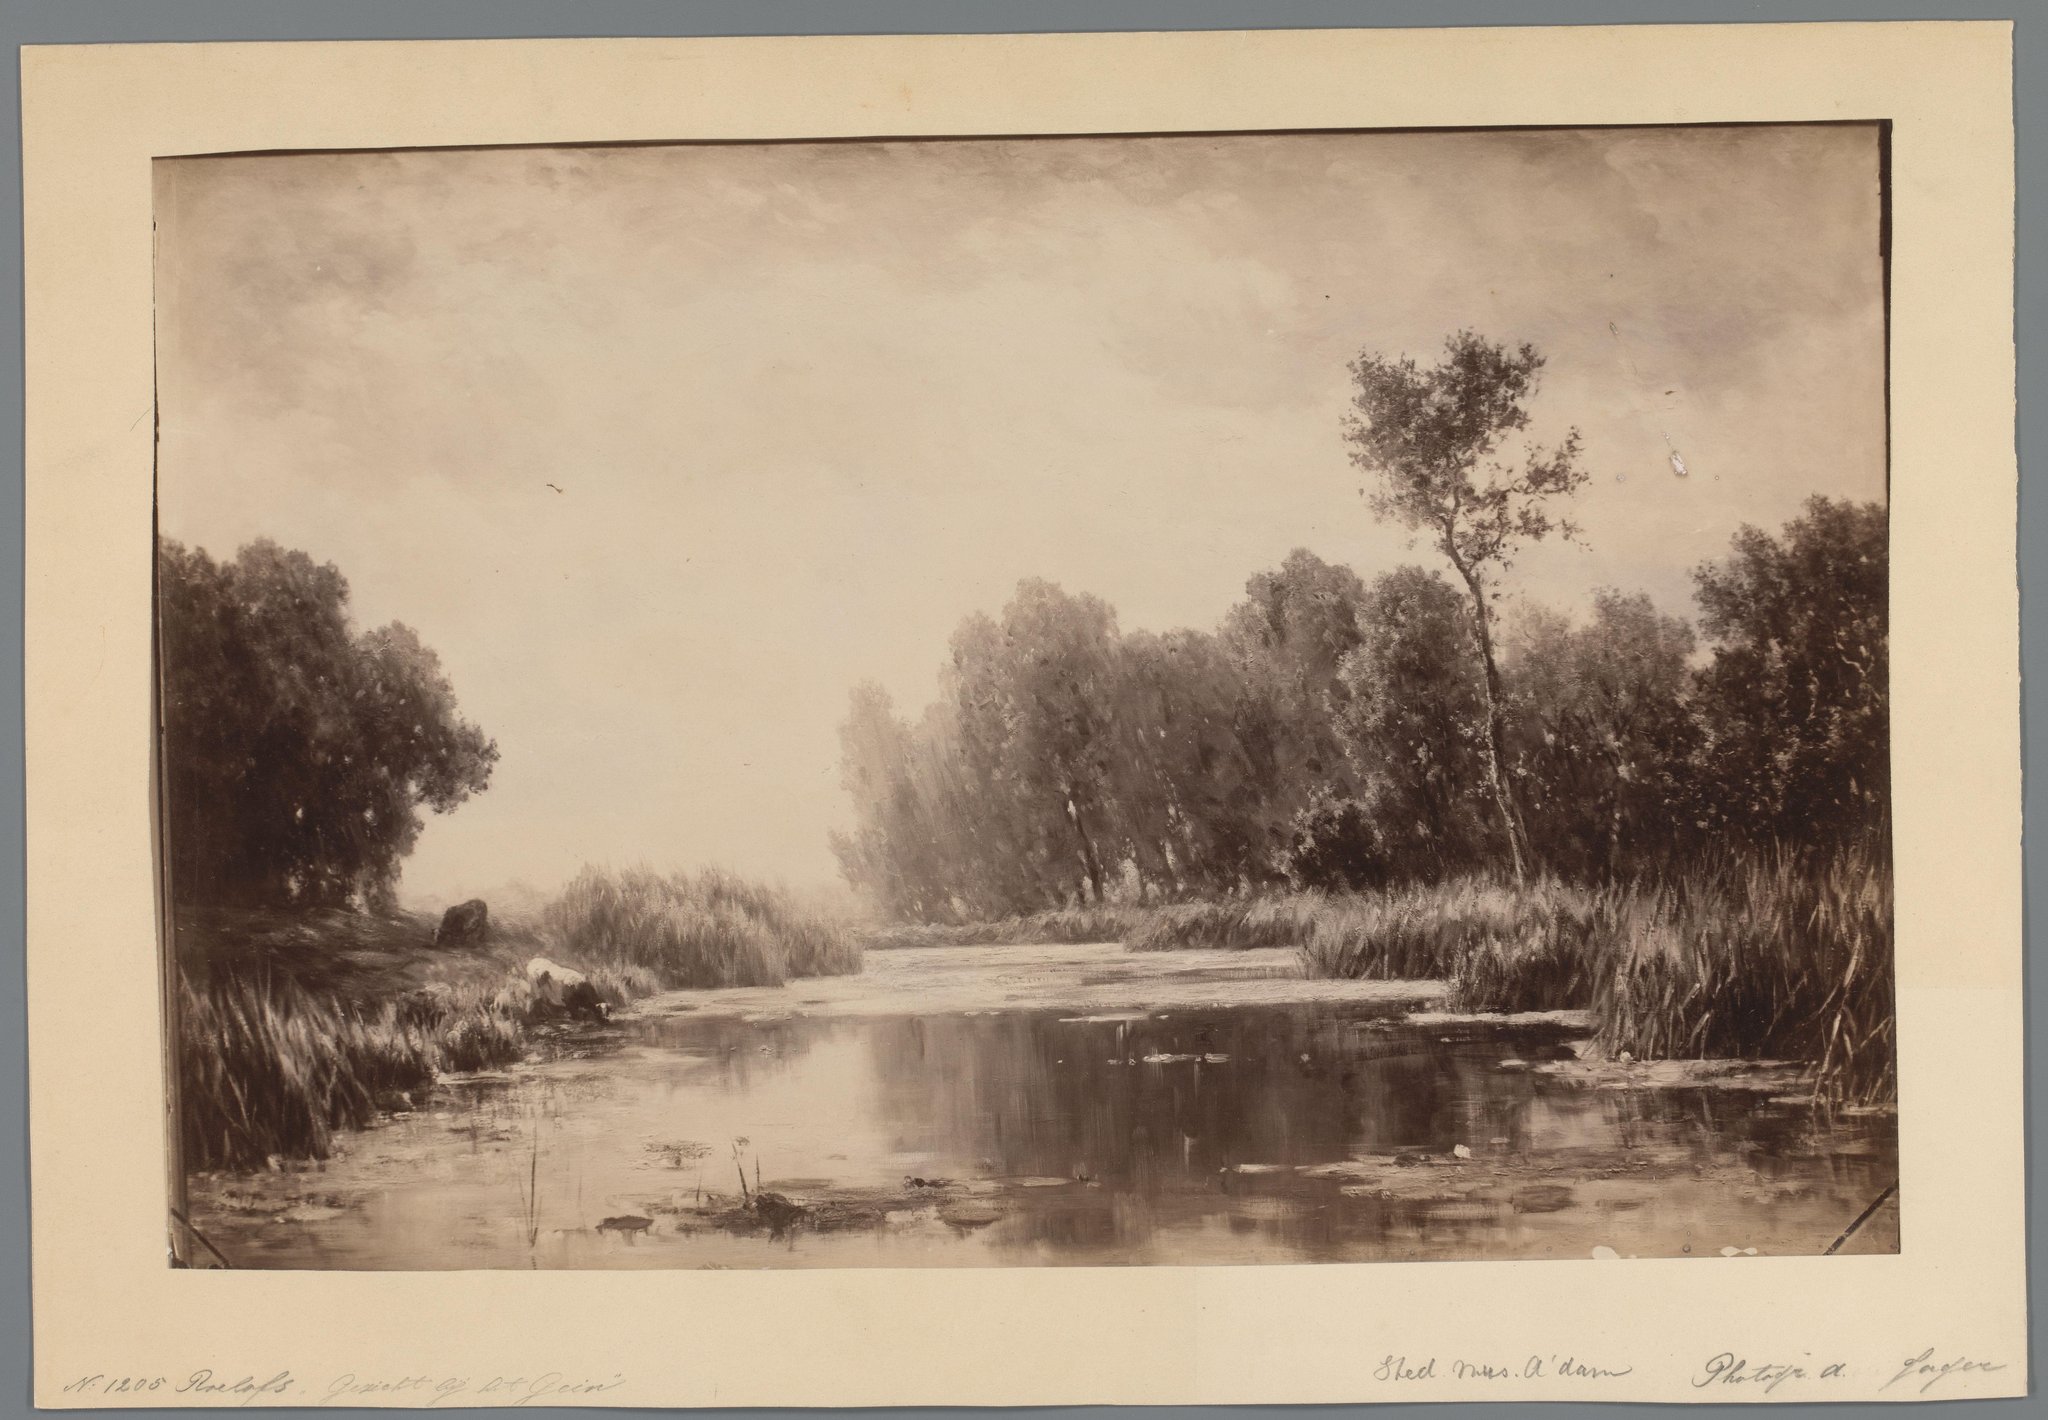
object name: photograph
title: Fotoreproductie van het schilderij In 't Gein bij Abcoude door Willem Roelofs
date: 1877-1895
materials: cardboard, paper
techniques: carbon print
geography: amsterdam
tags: river, abcoude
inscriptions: inscription: ‘N. 1205 (...) Sted. Mus. A'dam’